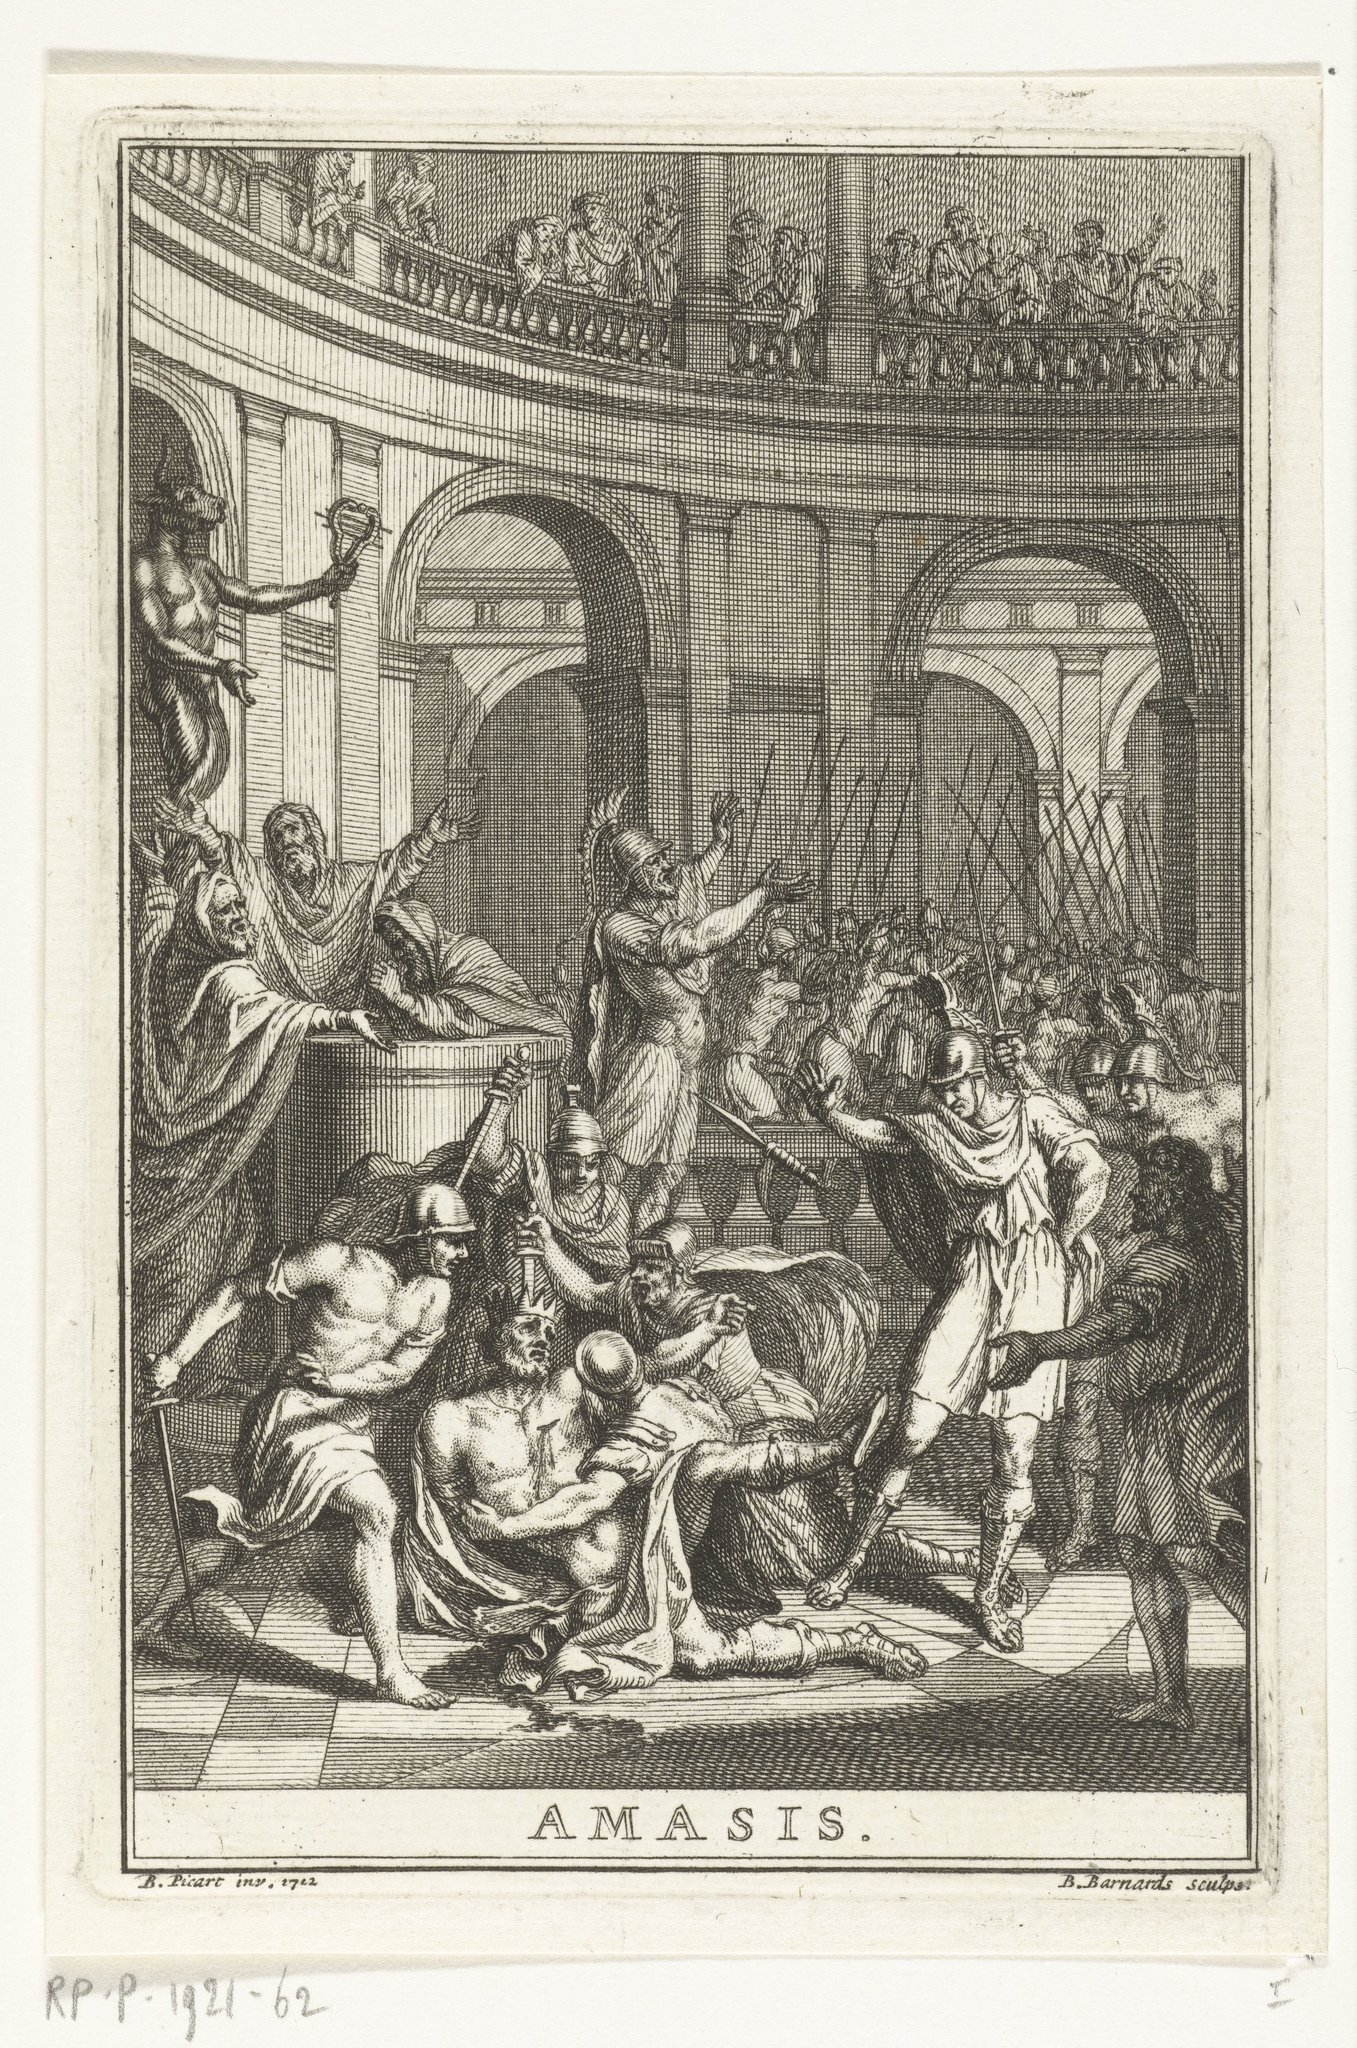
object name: print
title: Titelpagina voor François Joseph de Lagrange Chancel "Amasis, tragedie"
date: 1711-1737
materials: paper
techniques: engraving, etching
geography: amsterdam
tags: murder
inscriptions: collector's mark: Lugt 2233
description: In het koninklijk paleis van Egypte wordt de koning neergestoken. Hij ligt op de grond en wijst naar zijn moordenaar.